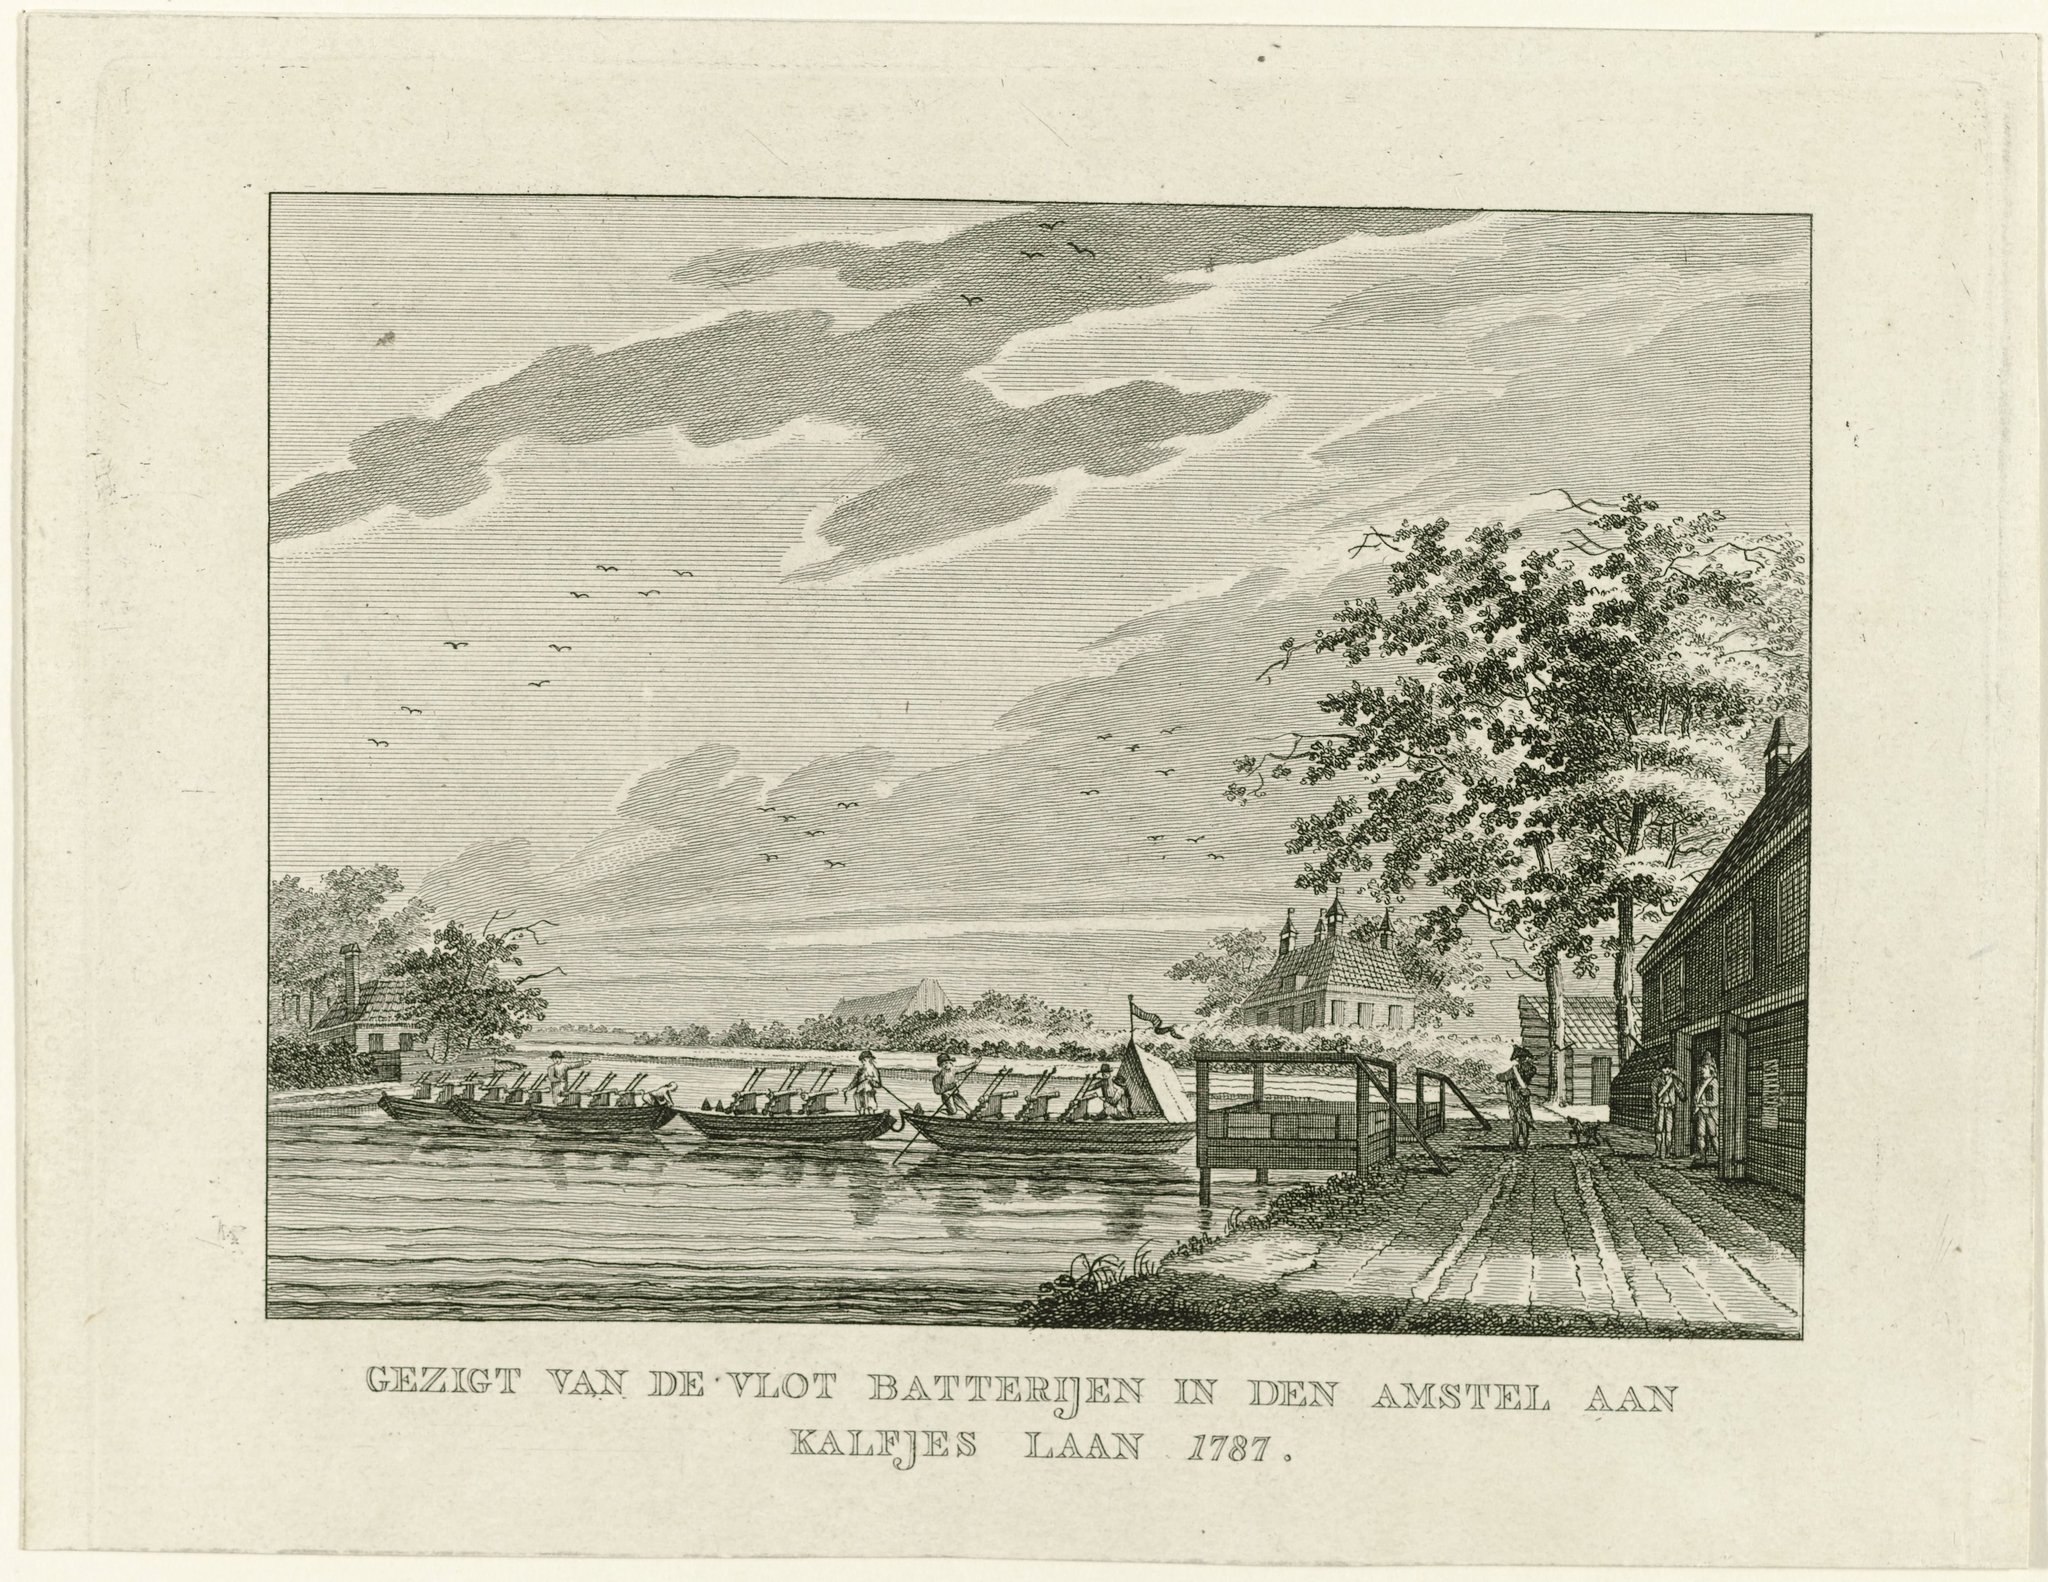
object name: print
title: Gezigt van de vlot batterijen in den Amstel aan Kalfjes Laan 1787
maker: Anonymous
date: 1787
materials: paper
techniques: etching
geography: northern netherlands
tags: defence of fortification or city, defensive measures (military)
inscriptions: collector's mark: Lugt 2228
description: Barricade van boten met batterijen in de Amstel bij de Kalfjeslaan. Onderdeel van een serie van veertien platen van de verdedigingen aangelegd door de patriotten rondom Amsterdam ten tijde van de inval van de Pruisische troepen in september 1787.